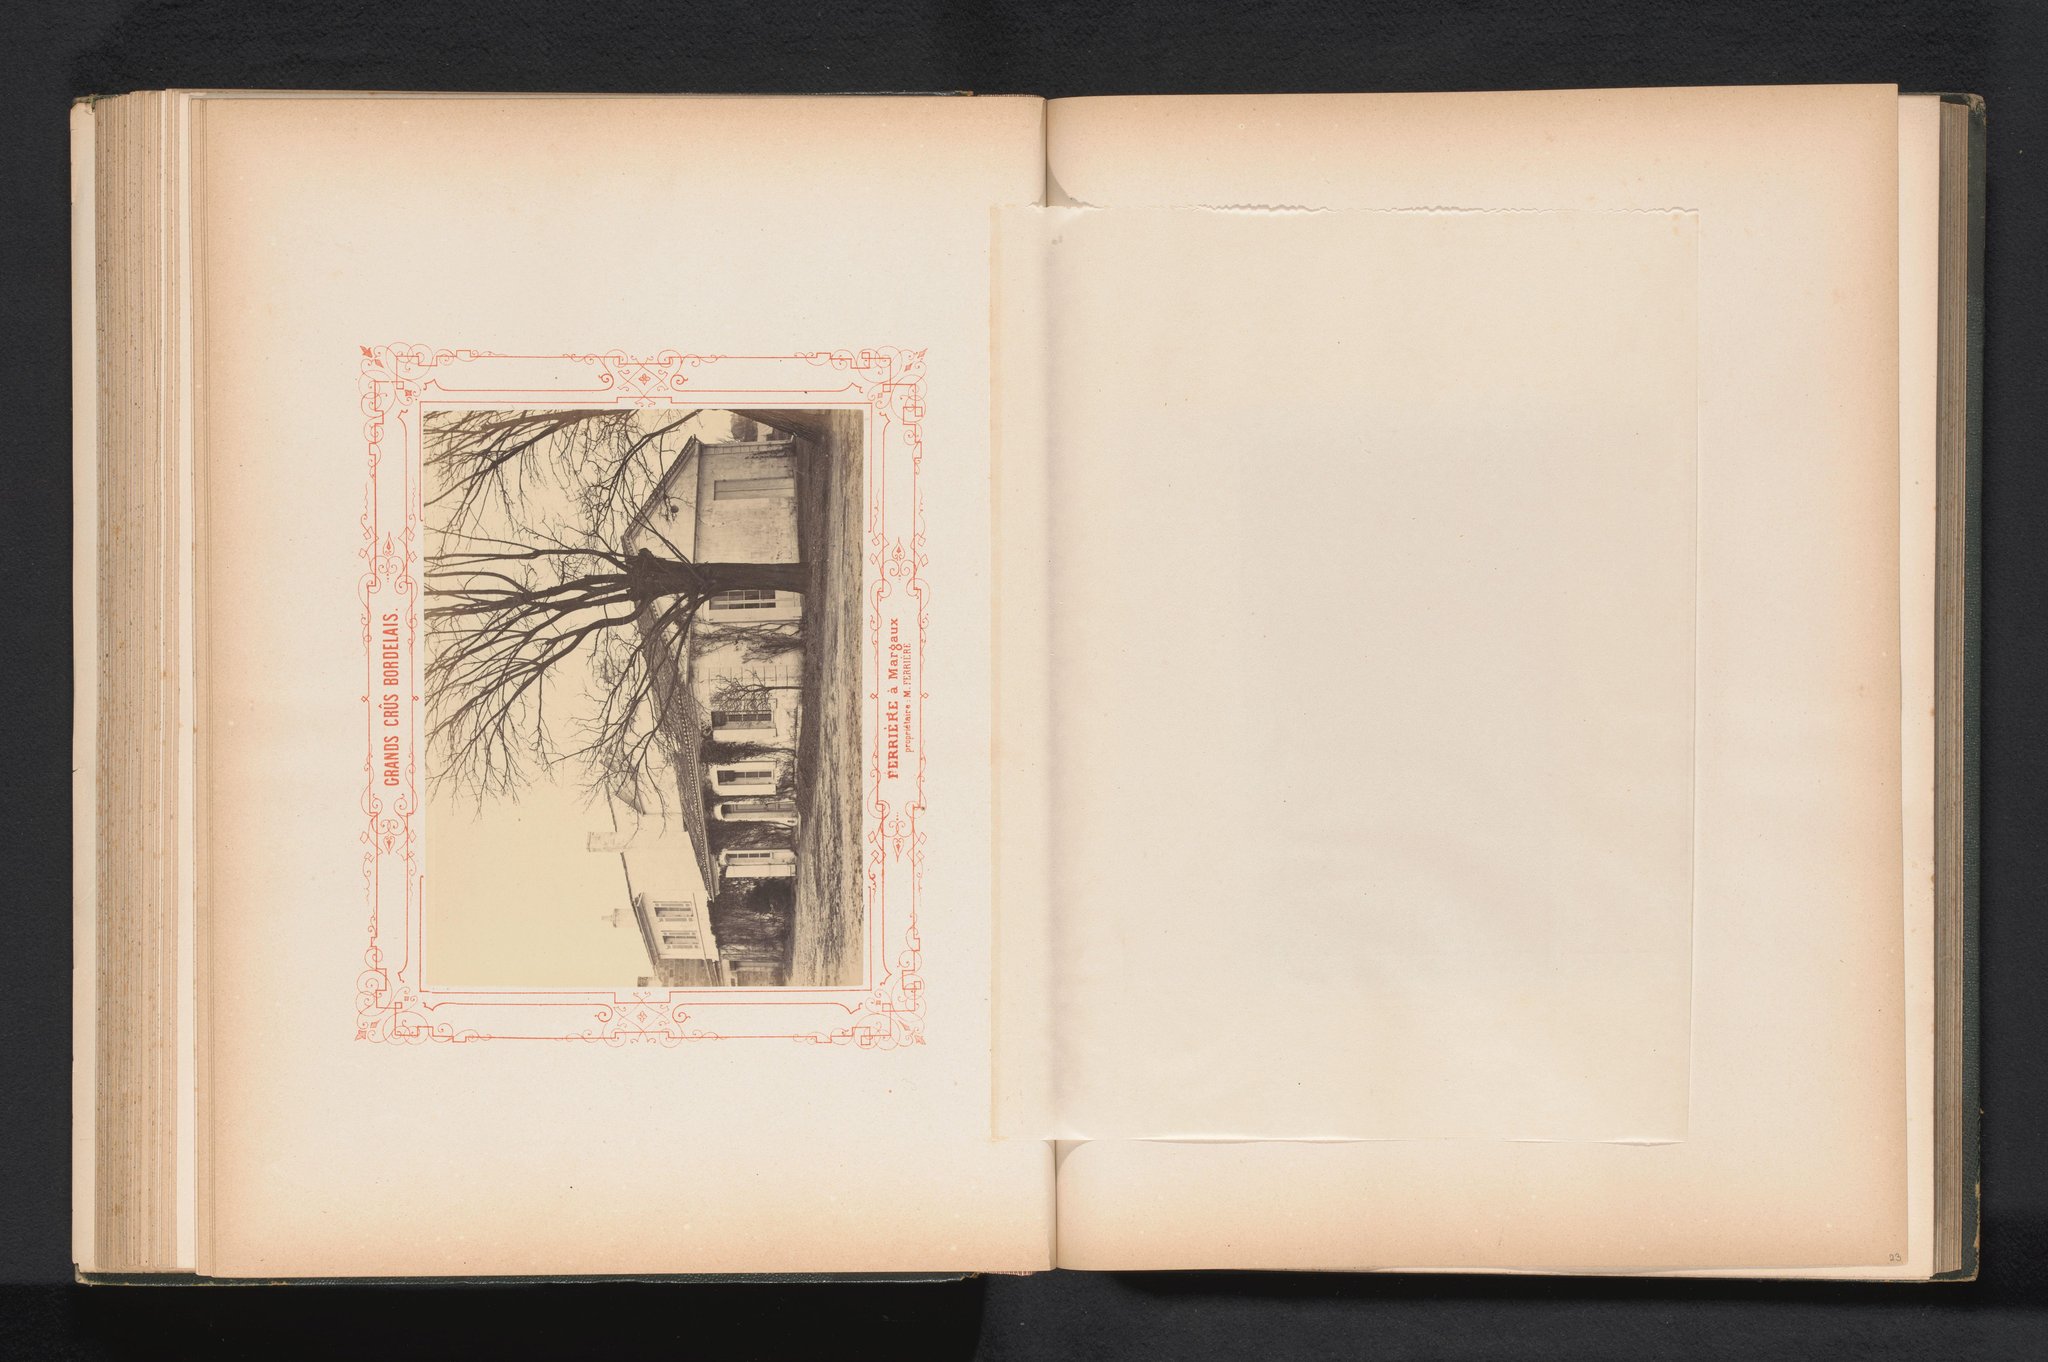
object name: page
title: Ferrière à Margaux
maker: alfred danflou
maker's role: fotograaf, schrijver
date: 1862-1867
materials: photographic support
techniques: albumen print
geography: margaux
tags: castle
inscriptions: inscription: ‘propriétaire: M. FERRIÈRE.’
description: Foto op negende ongenummerde pagina na pagina 83.